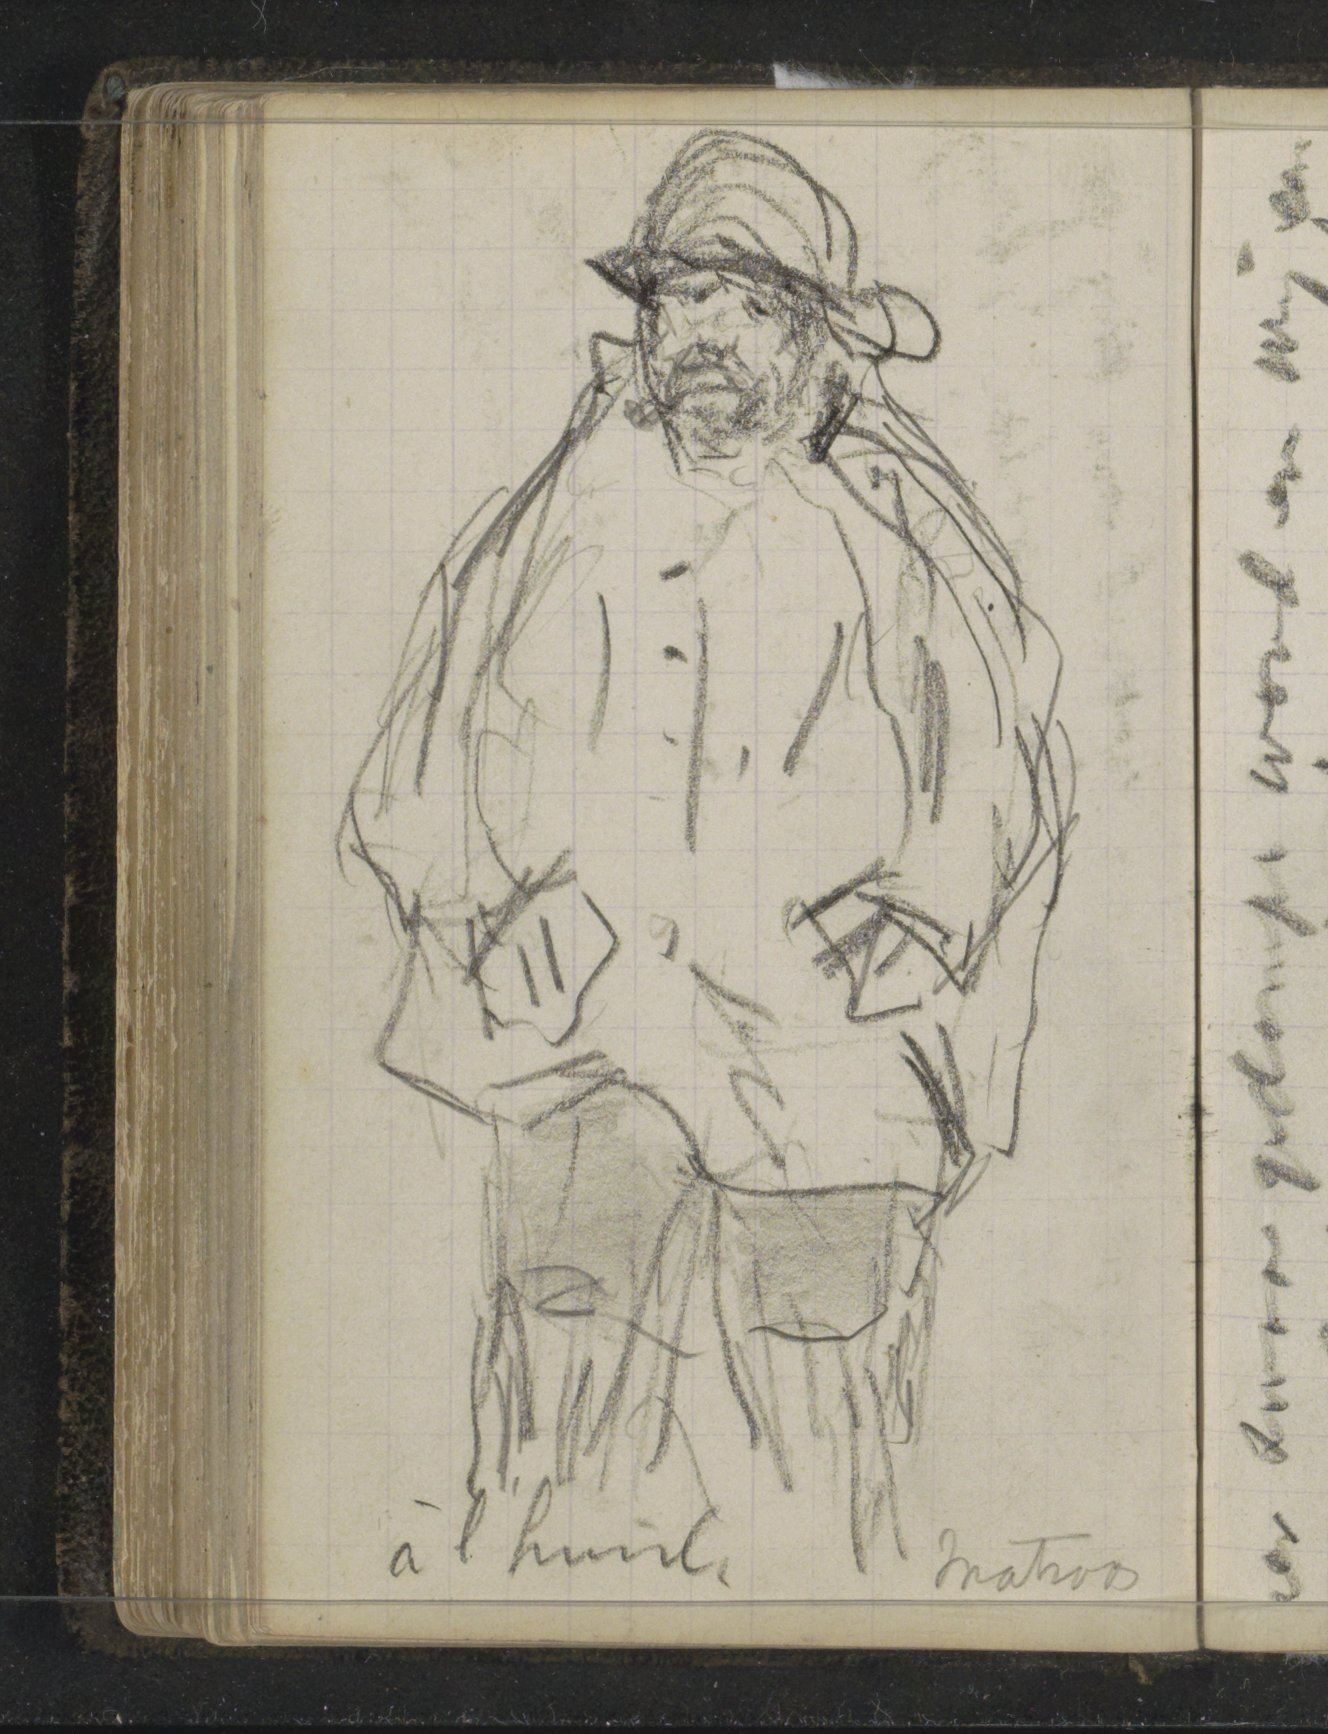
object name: sketchbook leaf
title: Matroos met zuidwester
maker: louis apol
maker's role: draughtsman, painter, print maker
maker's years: 1850-1936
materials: chalk, pencil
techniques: stumping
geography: novaya zemlya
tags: seaman: sailor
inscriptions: annotation: ‘à l'[...] / matroos’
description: Mogelijk een bemanningslid van de schoener Willem Barentsz. Blad 78 verso uit een schetsboek met 110 bladen betekend tijdens de expeditie naar Nova Zembla in 1880.